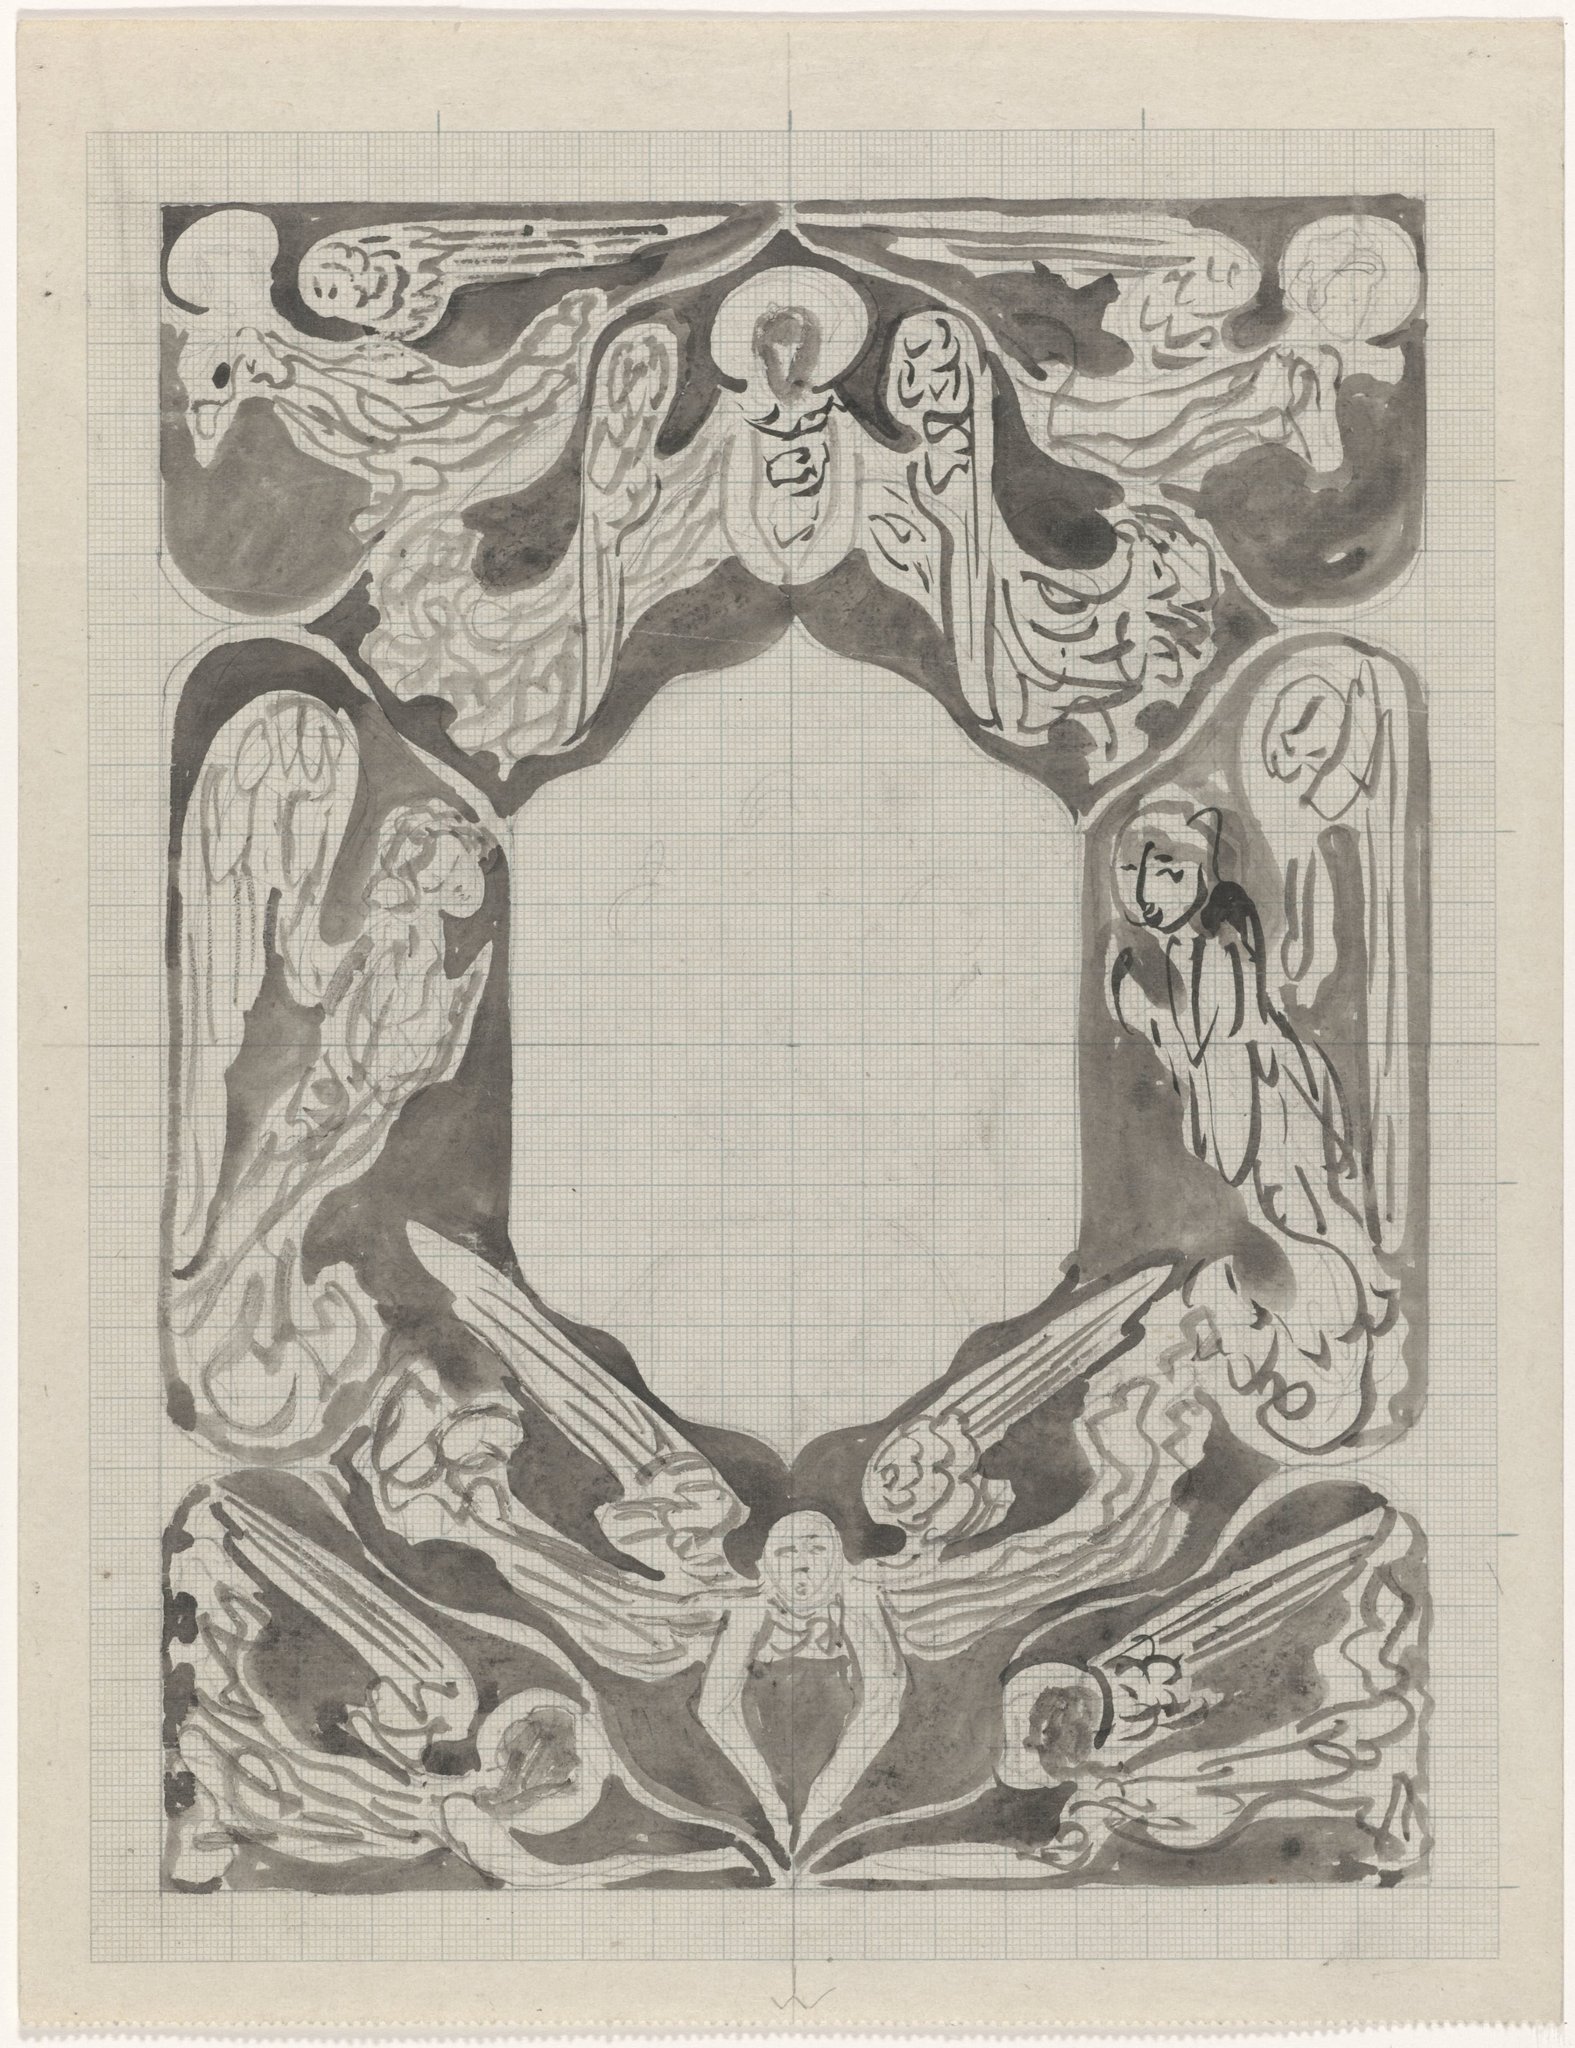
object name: drawing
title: Decoratief ontwerp met engelen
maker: carel adolph lion cachet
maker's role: draughtsman, print maker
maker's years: 1864-1945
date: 1874-1945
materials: paper, pencil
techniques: brush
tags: anthropomorphic ornament, lower angel(s)